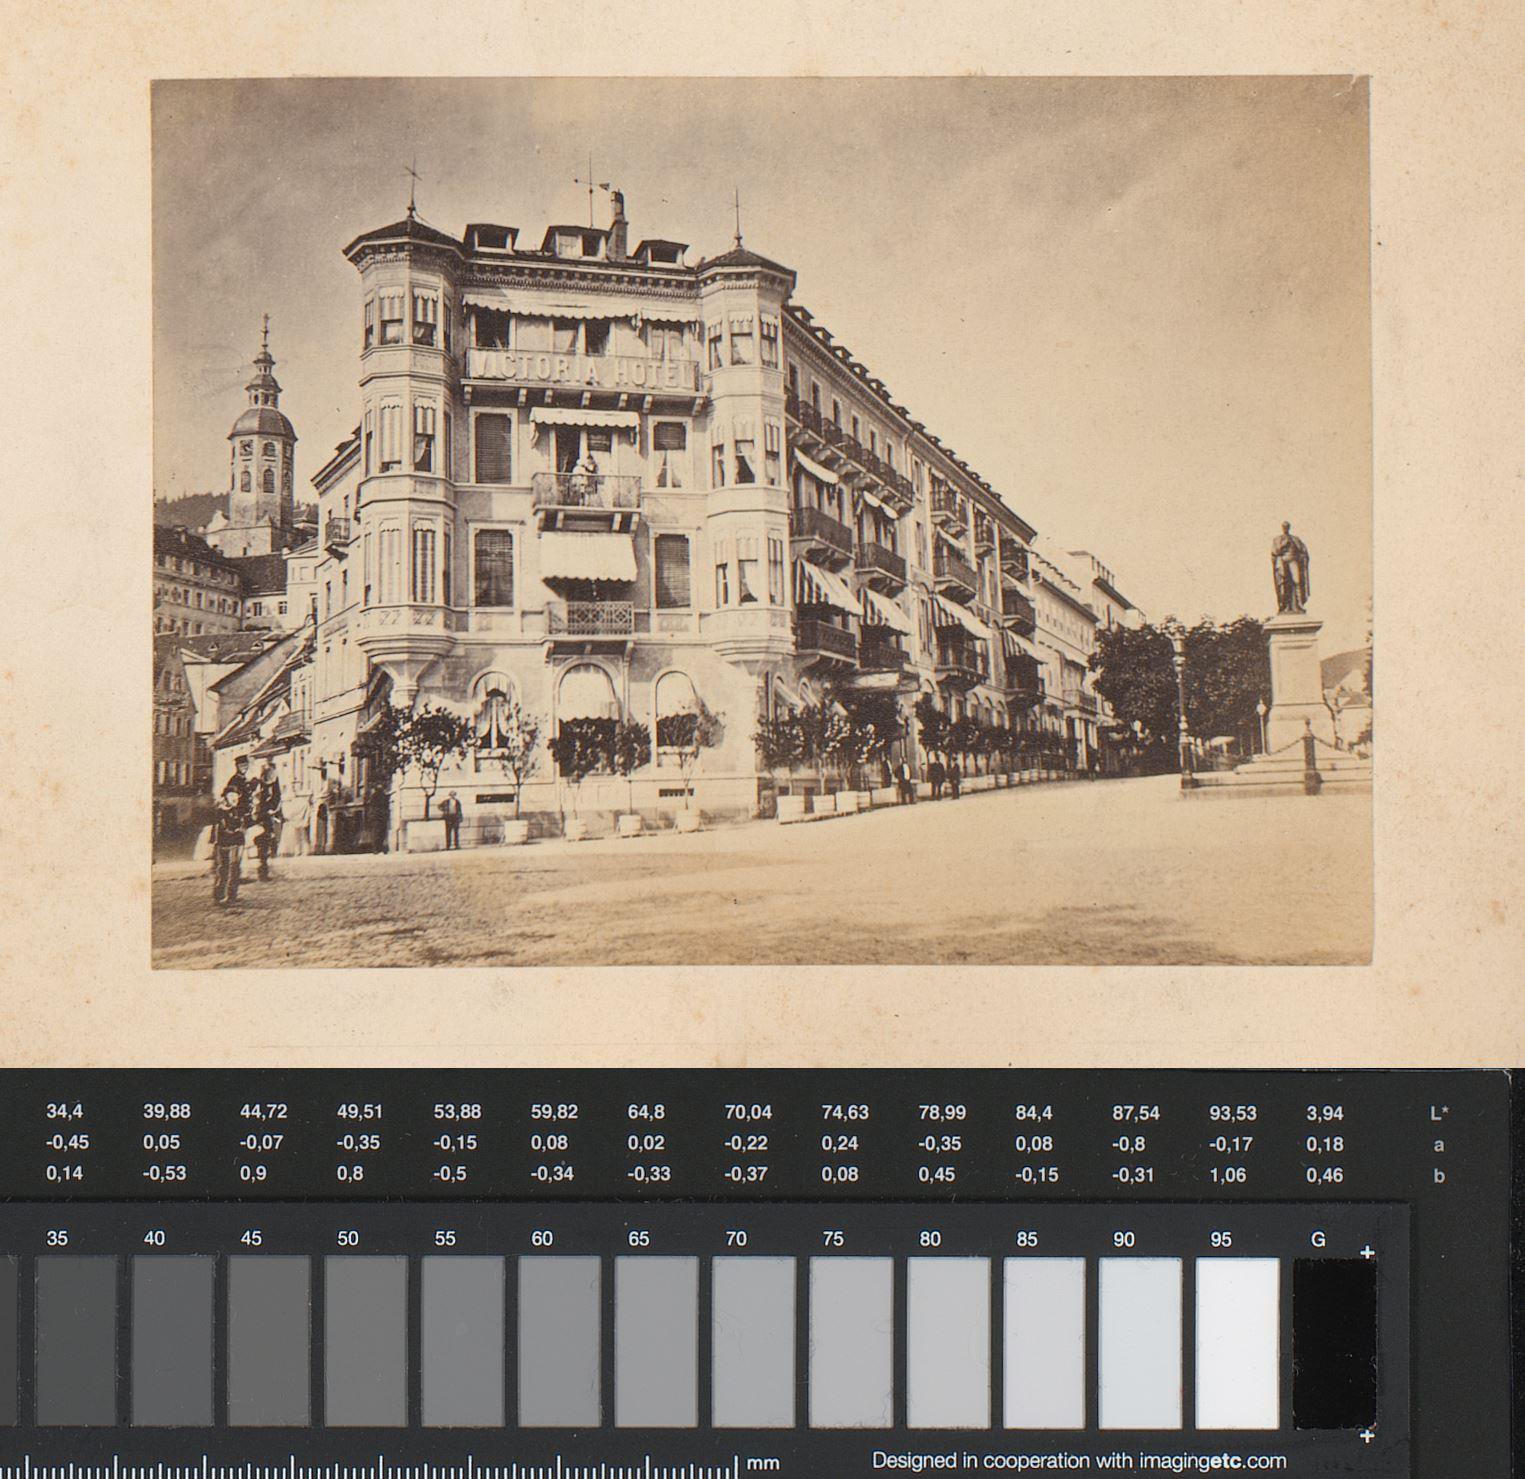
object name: album leaf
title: Gezicht op het Victoria Hotel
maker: Anonymous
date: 1860-1890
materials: paper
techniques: albumen print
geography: brussels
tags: exterior ~ representation of a building